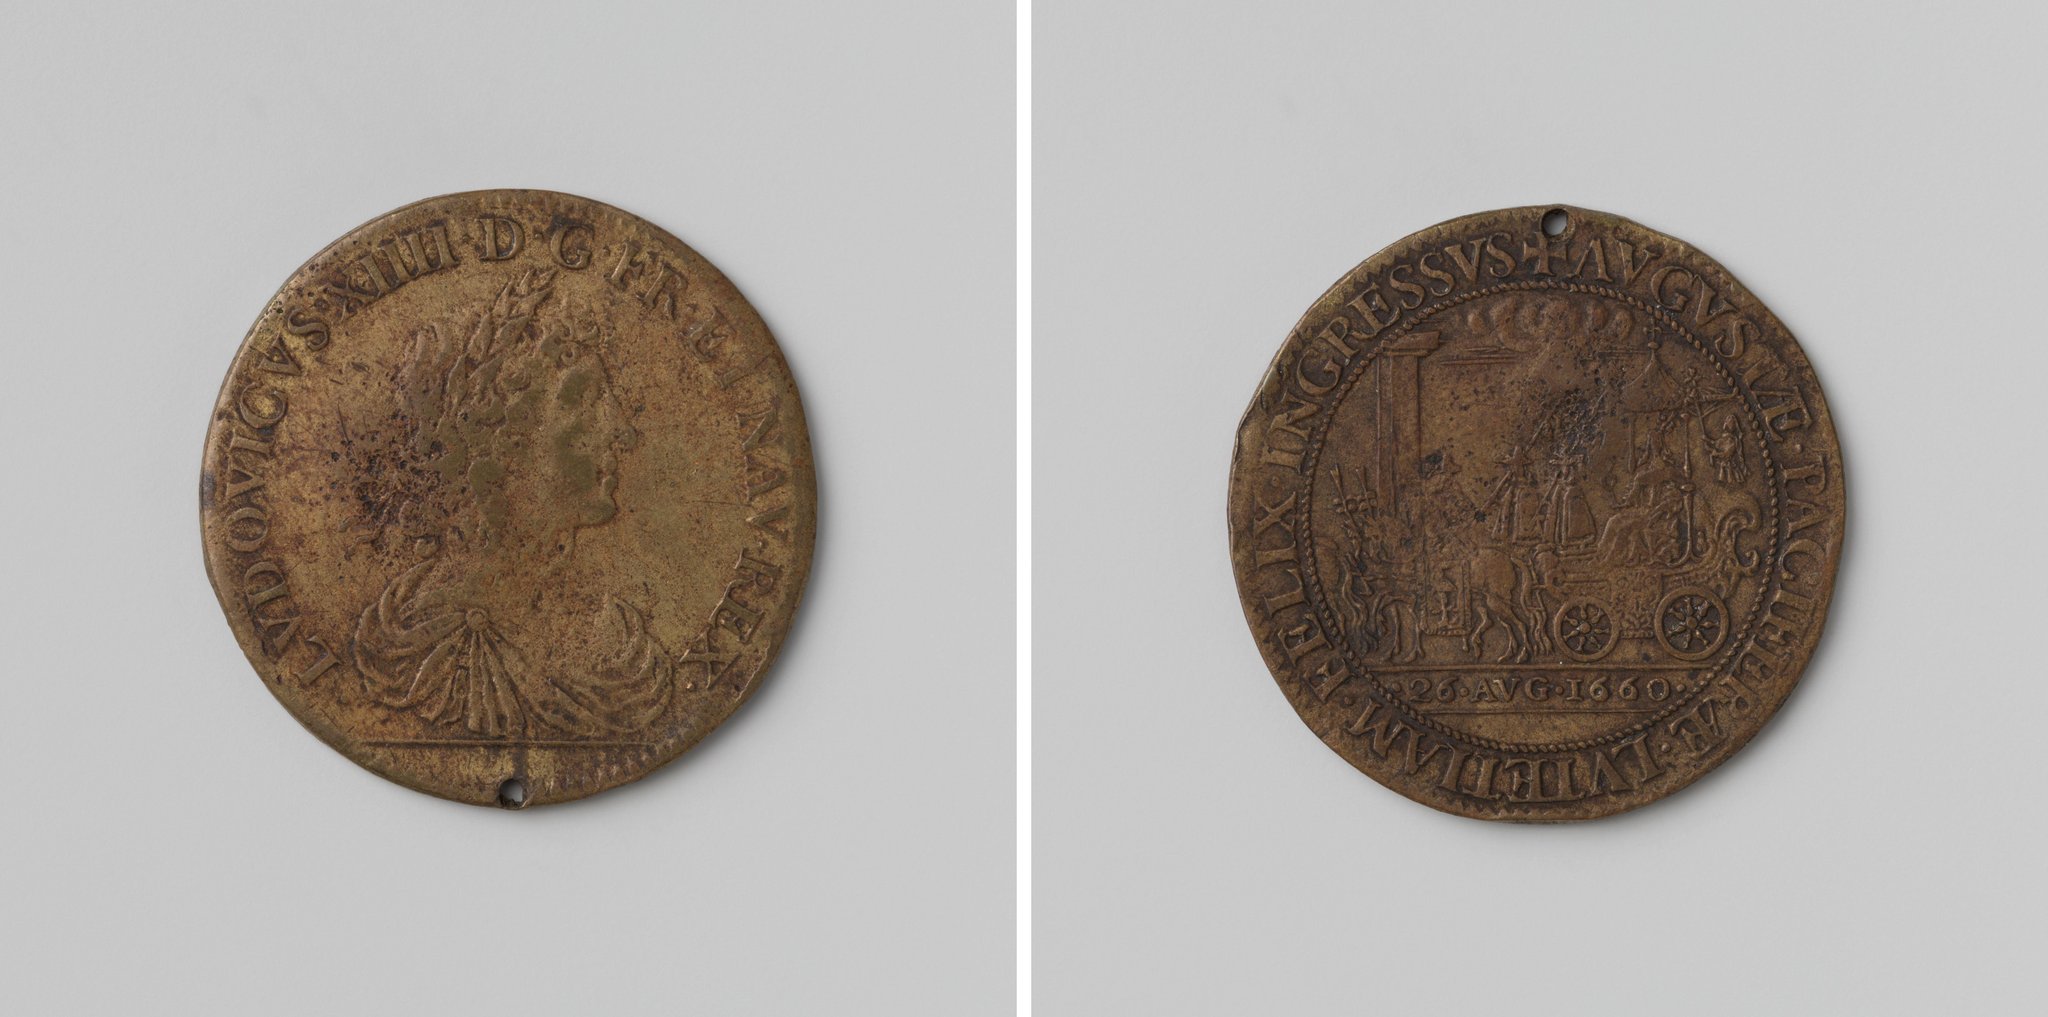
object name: jeton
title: Aankomst van Maria Theresia in Parijs, rekenpenning geslagen ter ere van Lodewijk XIV, koning van Frankrijk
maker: Anonymous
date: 1660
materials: copper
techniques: striking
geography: france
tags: lodewijk xiv (koning van frankrijk), maria theresia (koningin van frankrijk), paris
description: Koperen penning met gat erin. Voorzijde: borststuk man met lauwerkrans binnen omschrift. Keerzijde: koningin op zegewagen binnen omschrift; afsnede: datering